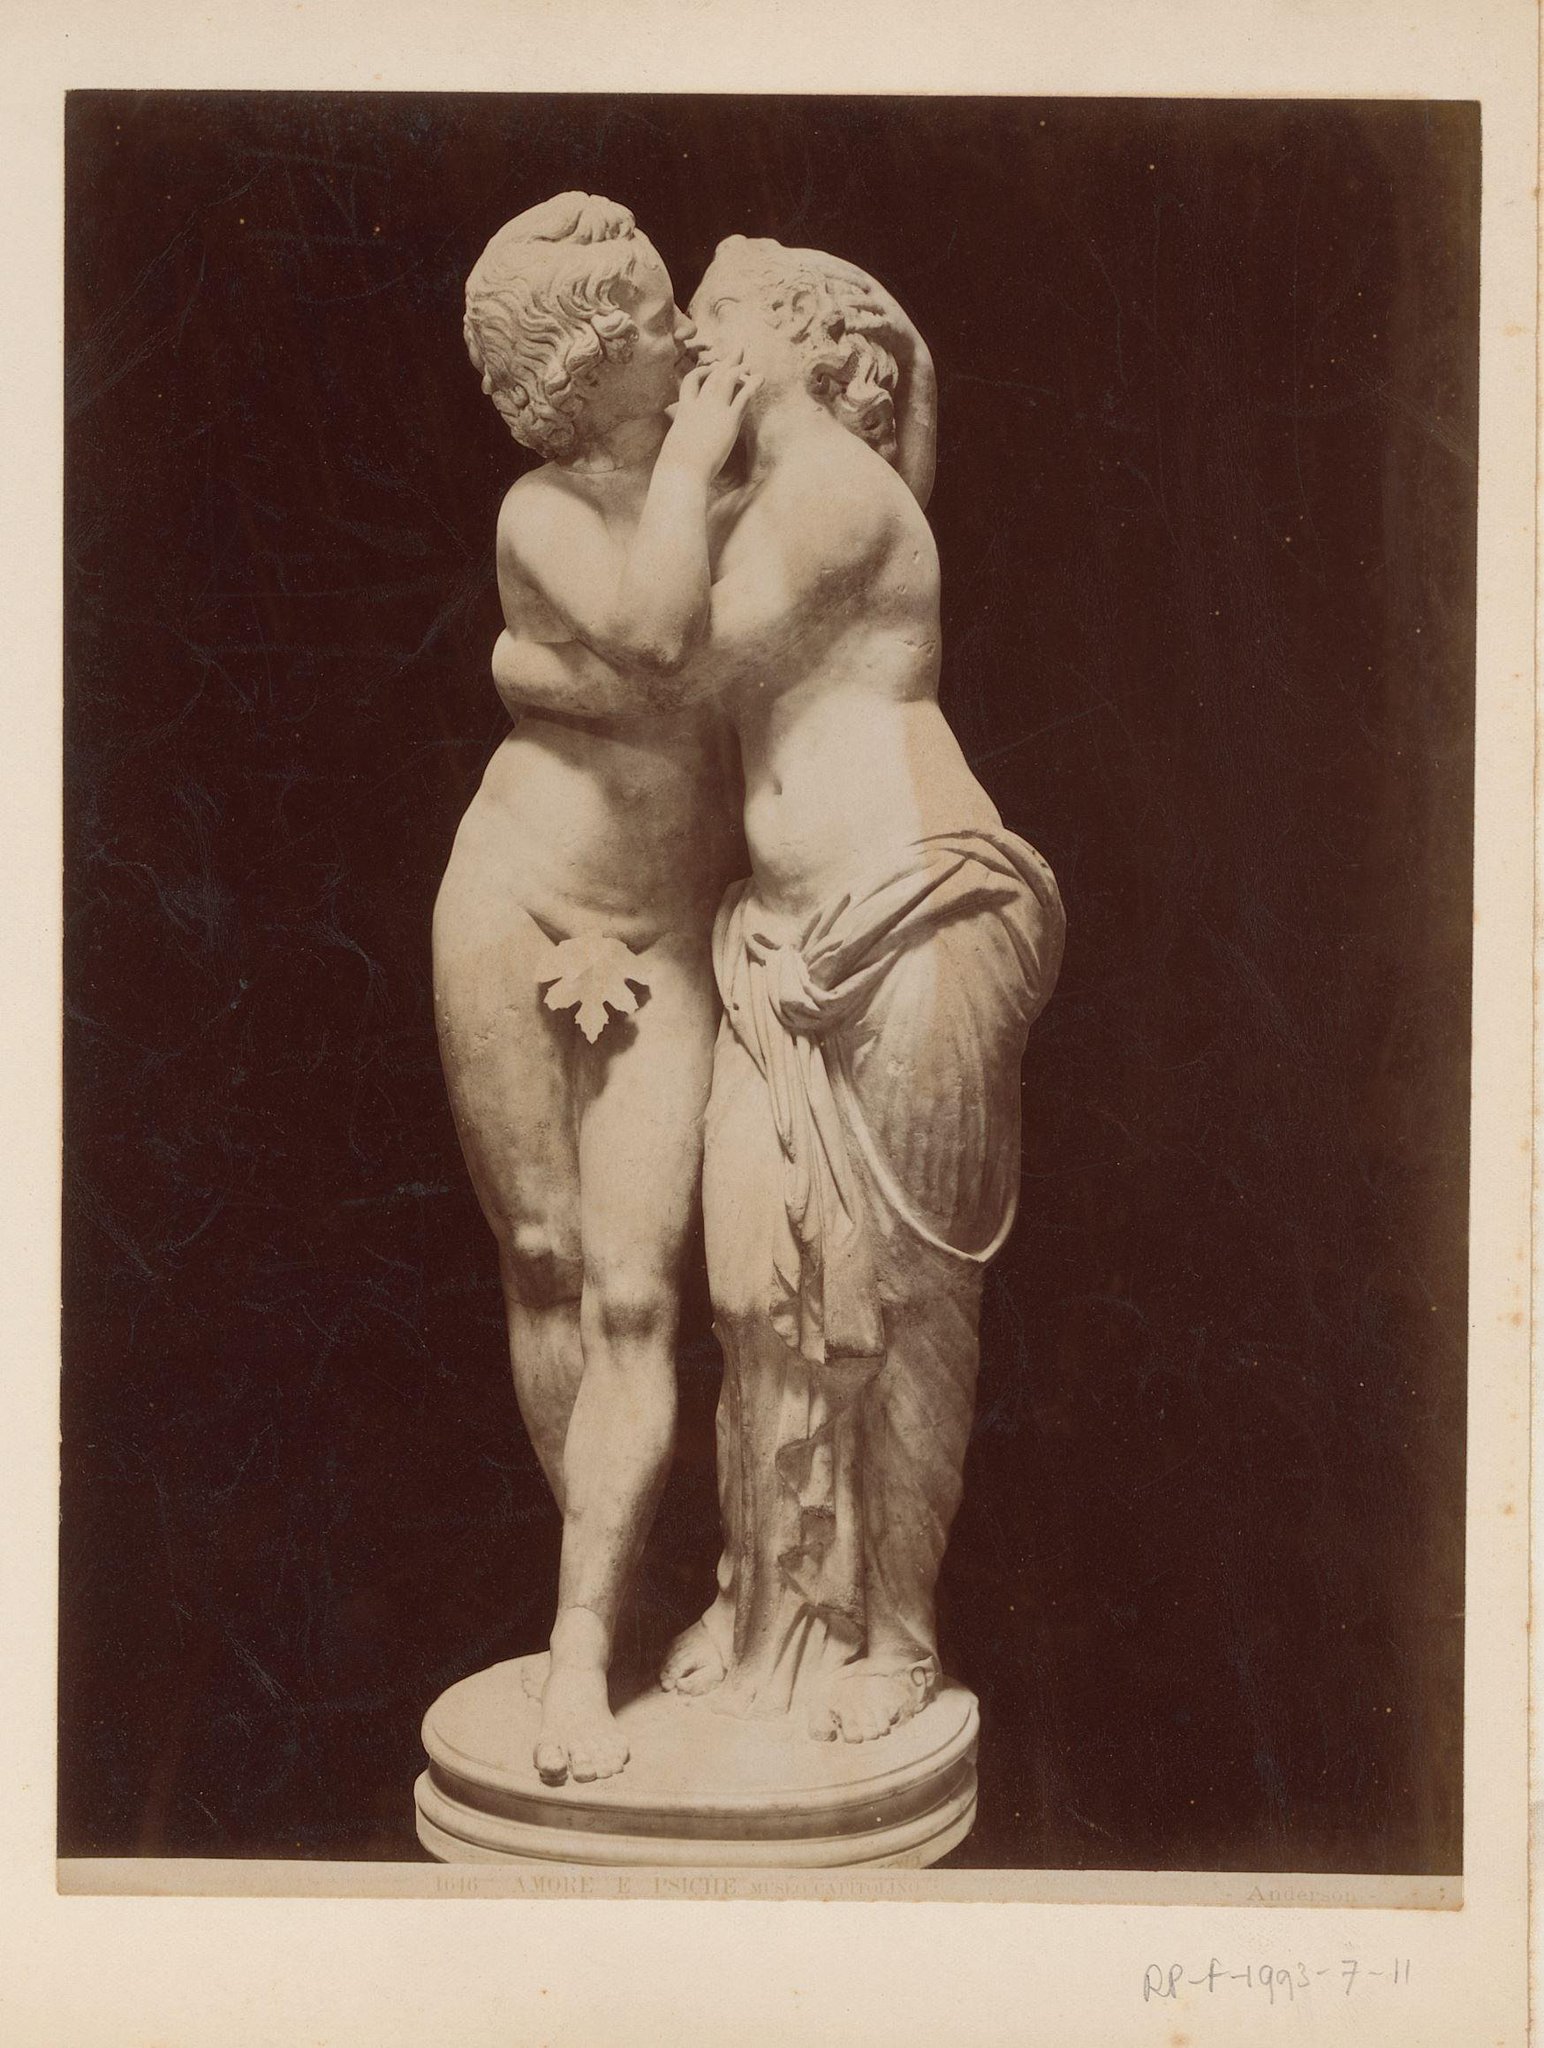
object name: album leaf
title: Sculptuur van Amor en Psyche in de Capitolijnse Musea te Rome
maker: james anderson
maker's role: fotograaf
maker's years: 1813-1877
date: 1857-1875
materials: paper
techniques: albumen print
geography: capitolijnse musea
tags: piece of sculpture, reproduction of a piece of sculpture, cupid and psyche as lovers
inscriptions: inscription: ‘1646 - AMORE E PSYCHE Museo Capitolano Anderson’